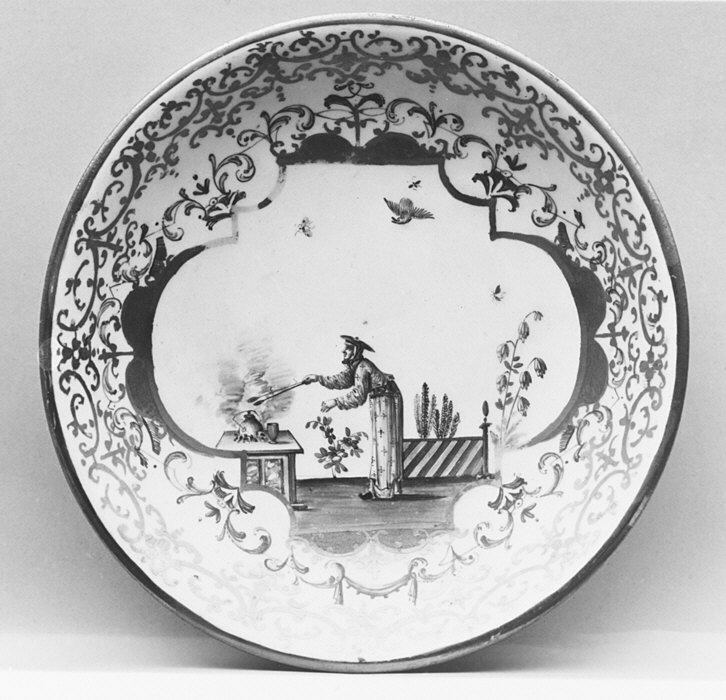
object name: saucer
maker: meissen manufactory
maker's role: manufactory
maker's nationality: german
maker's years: 1710-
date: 1725-1730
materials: hard paste porcelain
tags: men